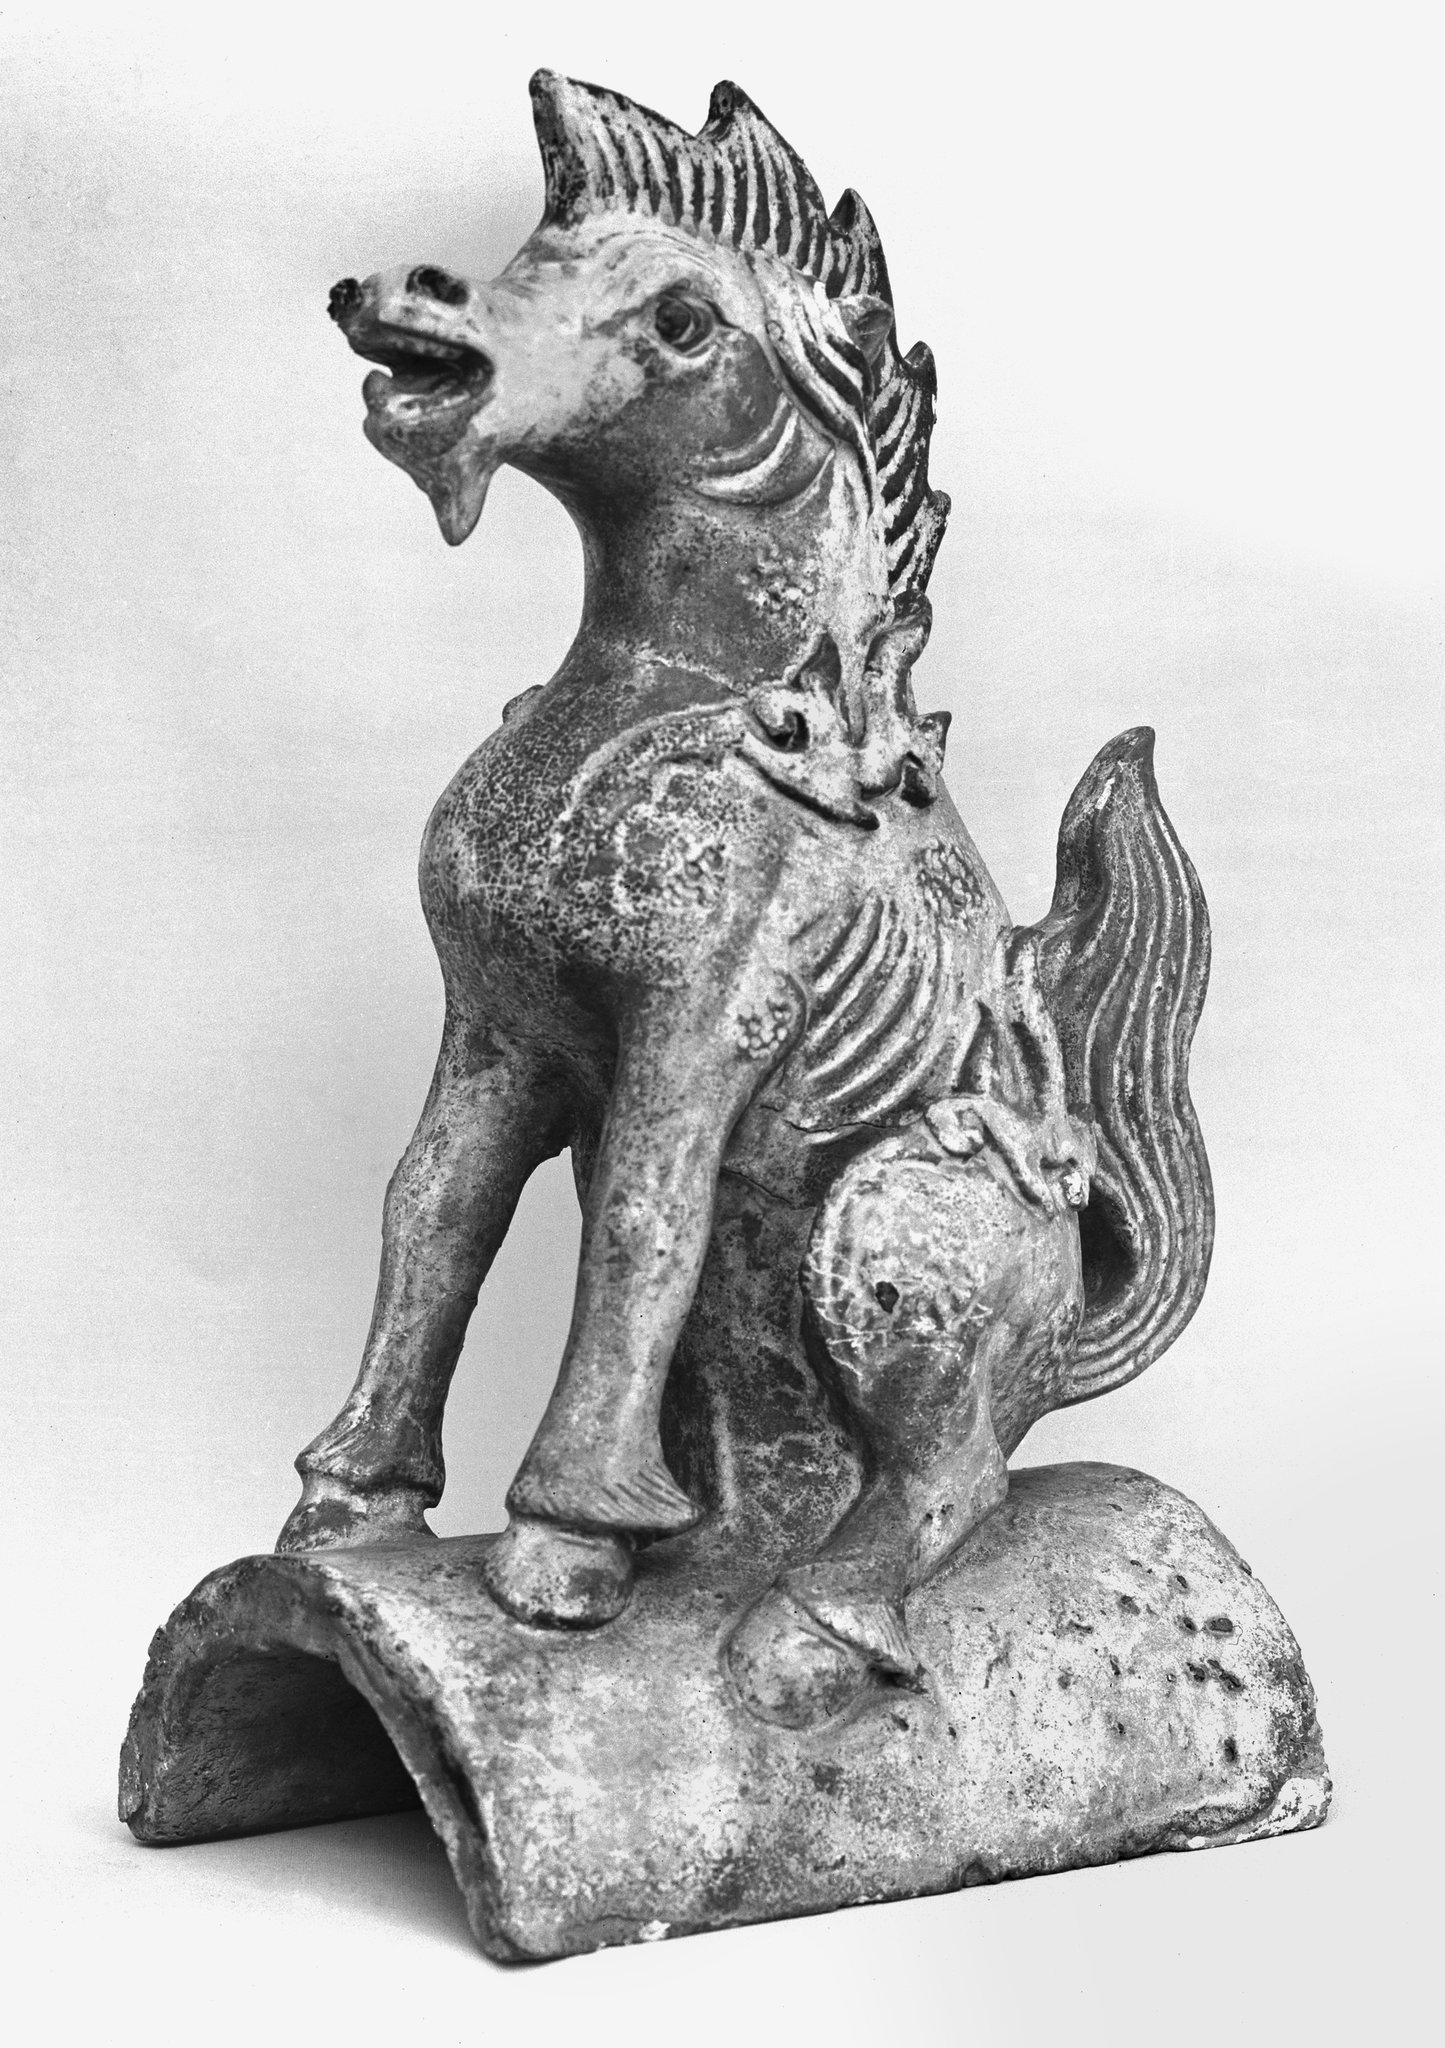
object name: roof tile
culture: chinese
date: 1368-1644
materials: ceramic, glaze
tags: horses